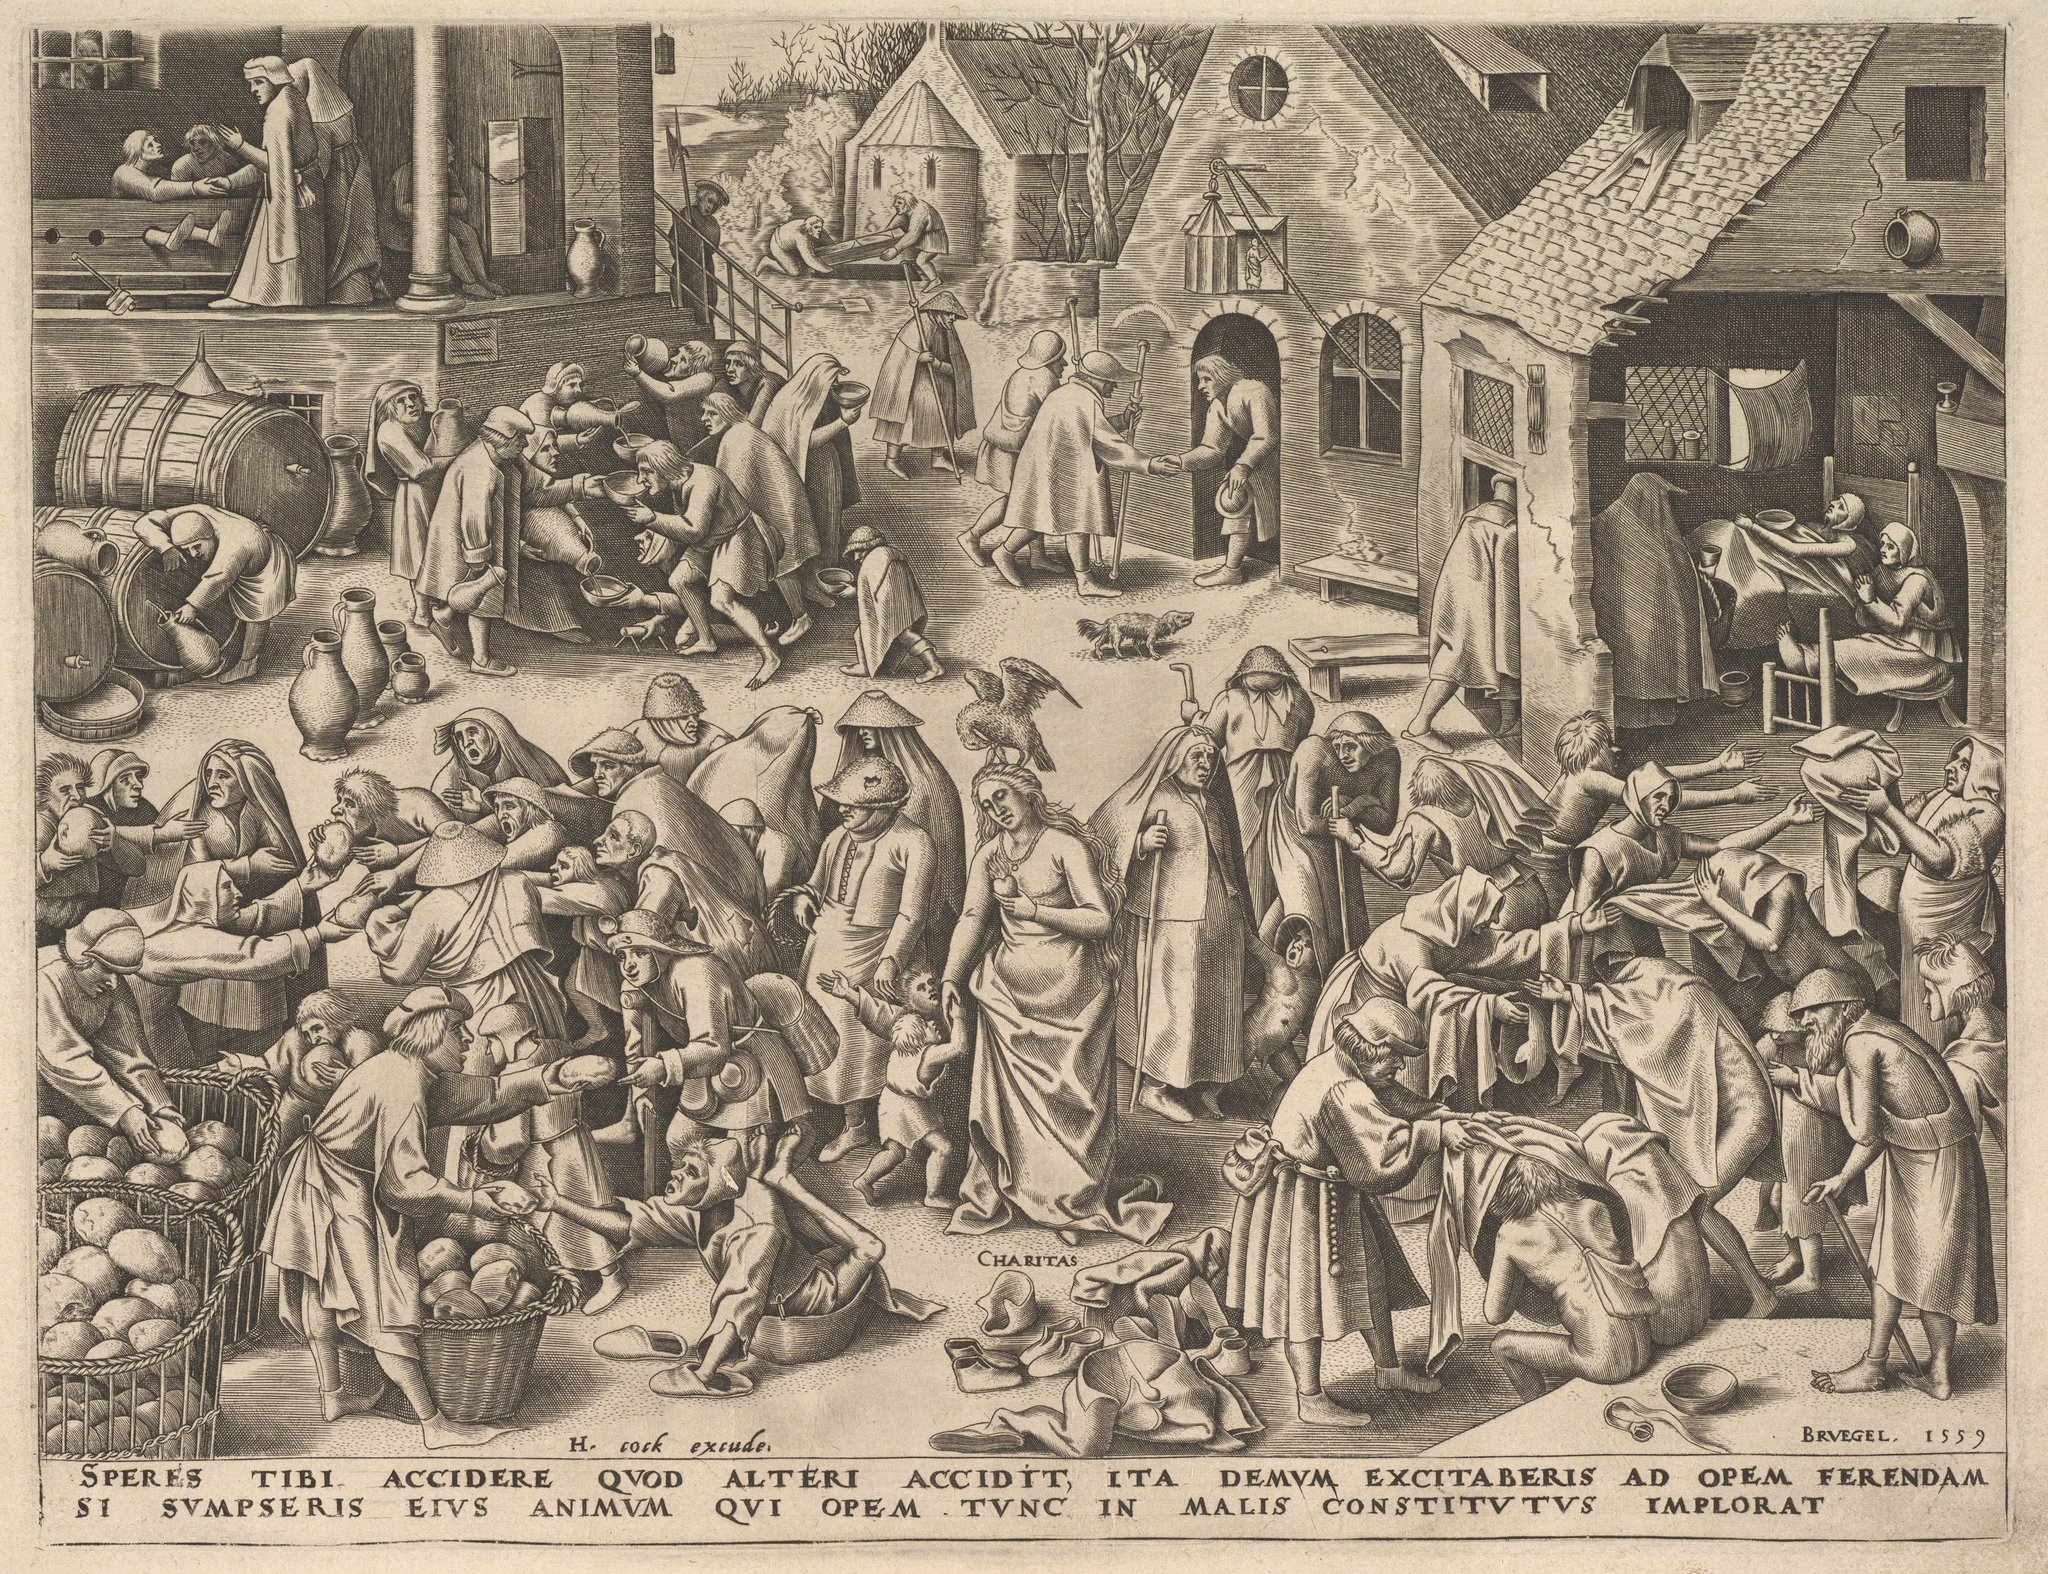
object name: print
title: Charity (Charitas) from The Virtues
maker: philips galle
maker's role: artist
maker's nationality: netherlandish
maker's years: 1537-1612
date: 1559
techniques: engraving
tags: food,suffering,men,women